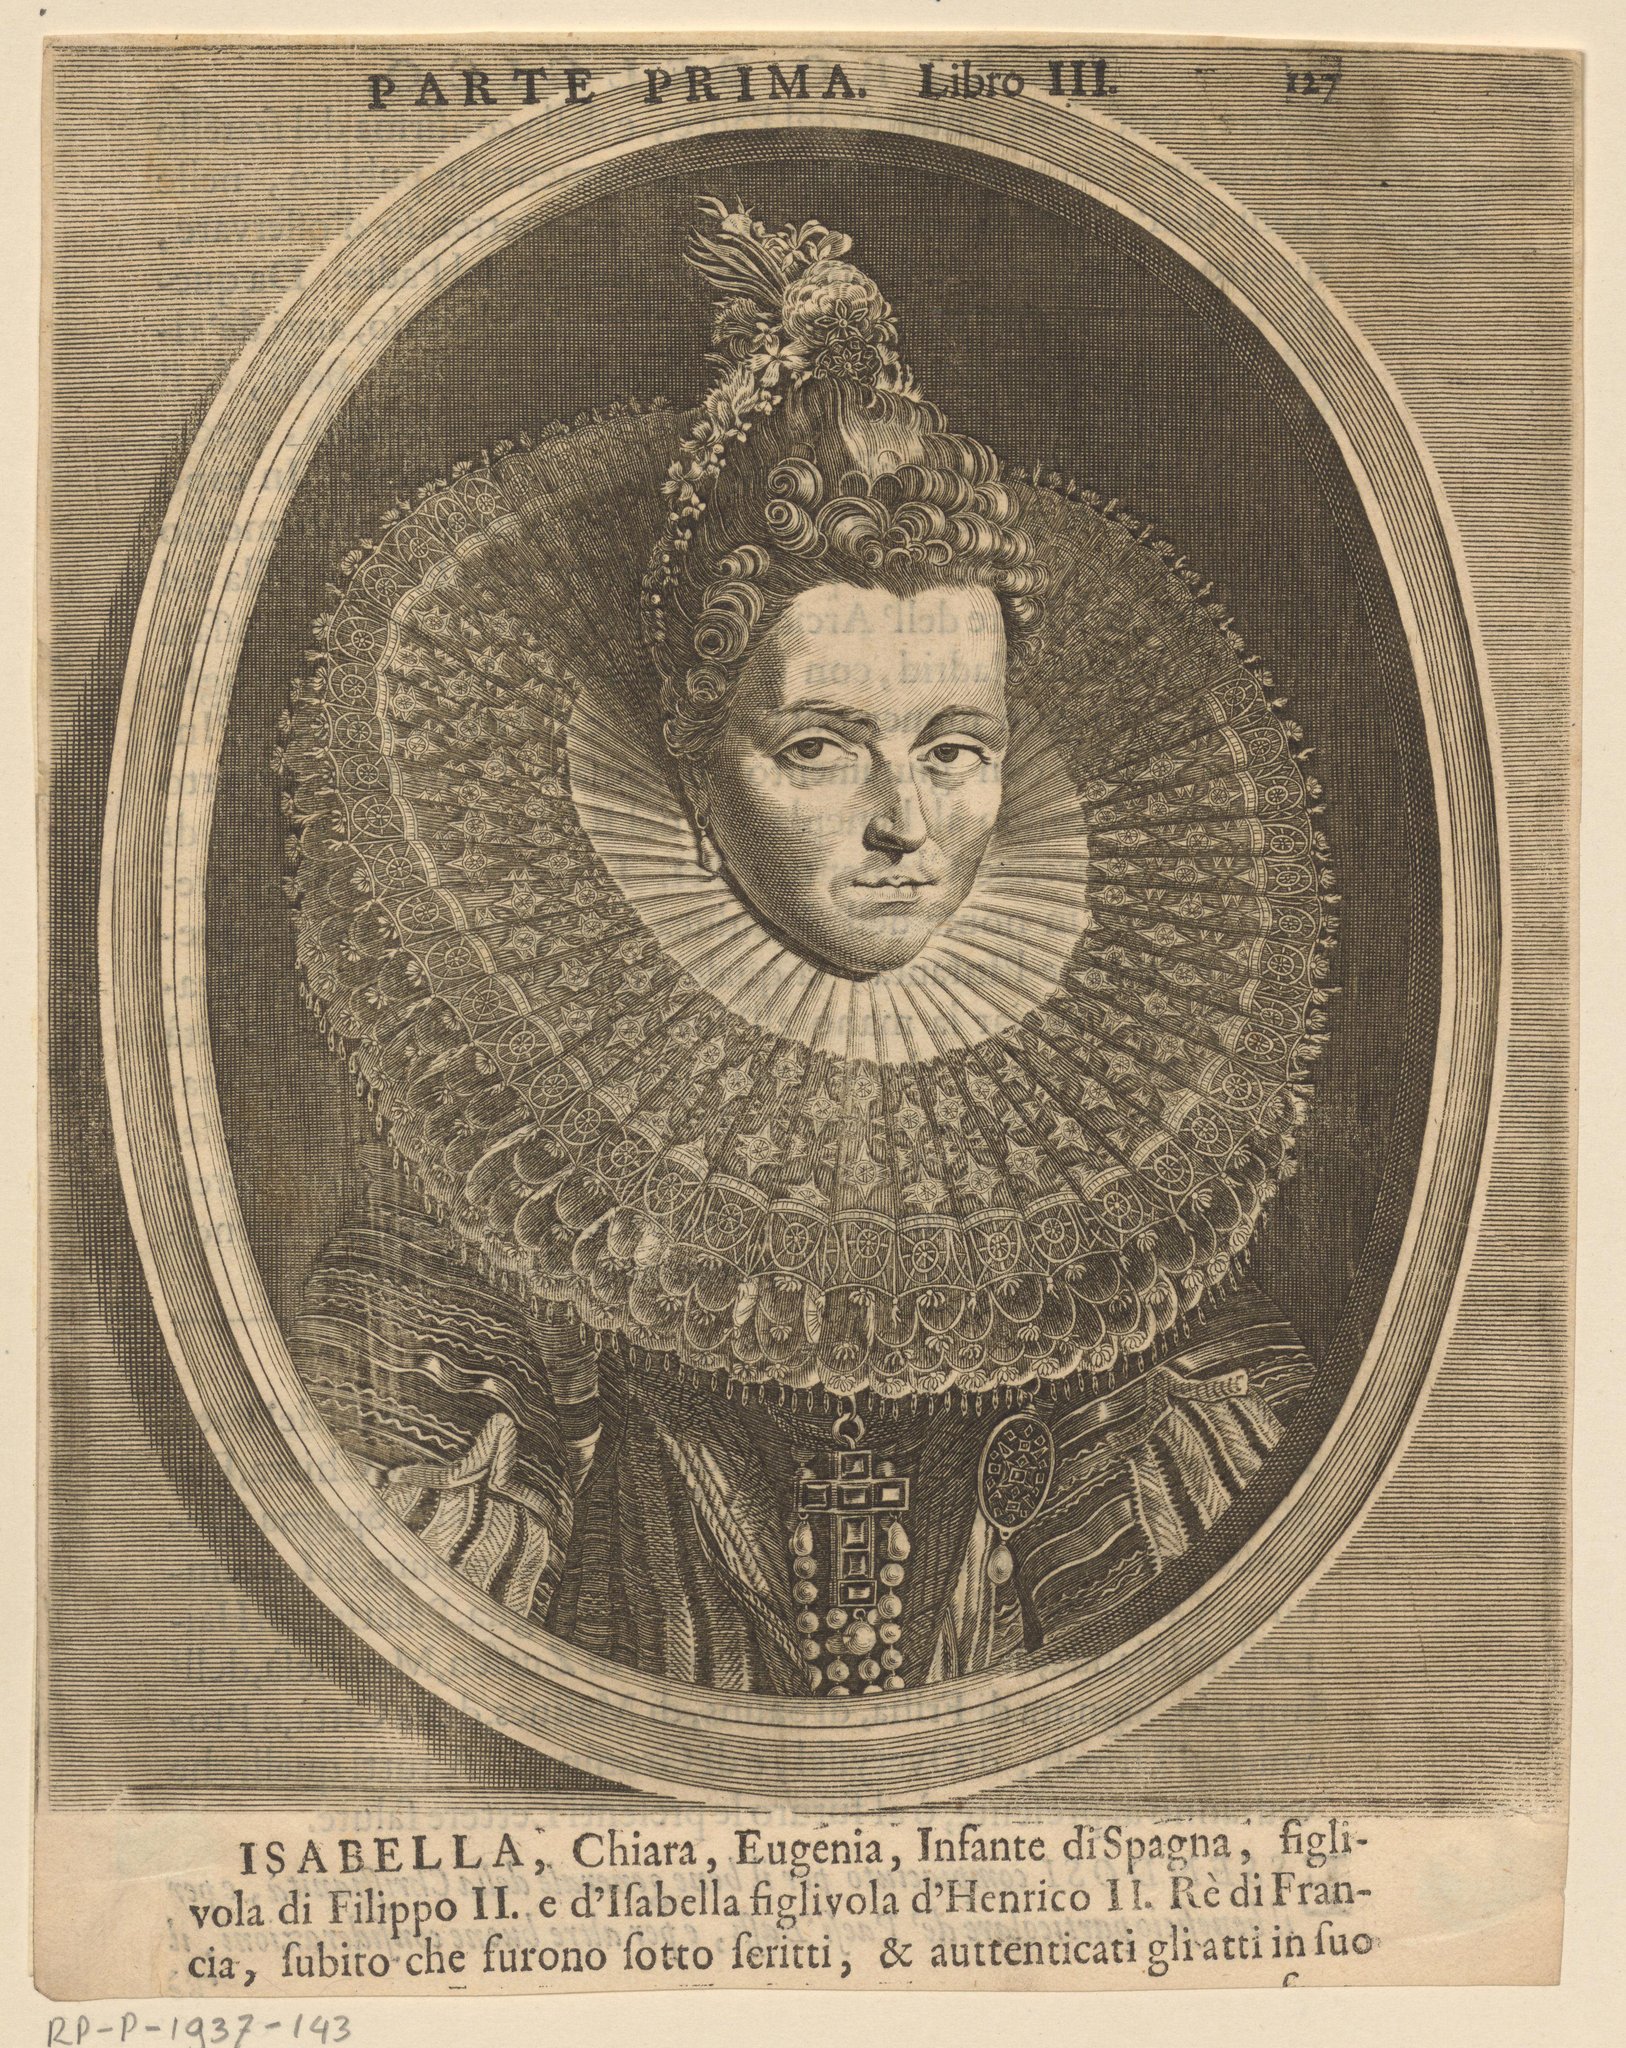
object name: book illustration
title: Portret van Isabella Clara Eugenia, infante van Spanje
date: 1690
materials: paper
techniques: engraving, letterpress printing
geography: amsterdam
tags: infante van spanje isabella clara eugenia, historical persons - bb - woman, ruler, sovereign - bb - female ruler, neck-gear: collar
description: Prent uit: Leti, Gregorio. Teatro Belgico, o vero ritratti historici (...). Amsterdam: Willem de Jonge, 1690, p. 127. Prent ook gebruikt in: Bor, Pieter. Oorsprongk, begin, en vervolgh der Nederlandsche oorlogen, beroerten (...). Amsterdam: weduwe Joannes van Someren et al.,1684. Latere staat van prent gebruikt in: Le Clerc, Jean. Geschiedenissen der Vereenigde Nederlanden (...). Amsterdam: Zacharias Chatelain, 1730.